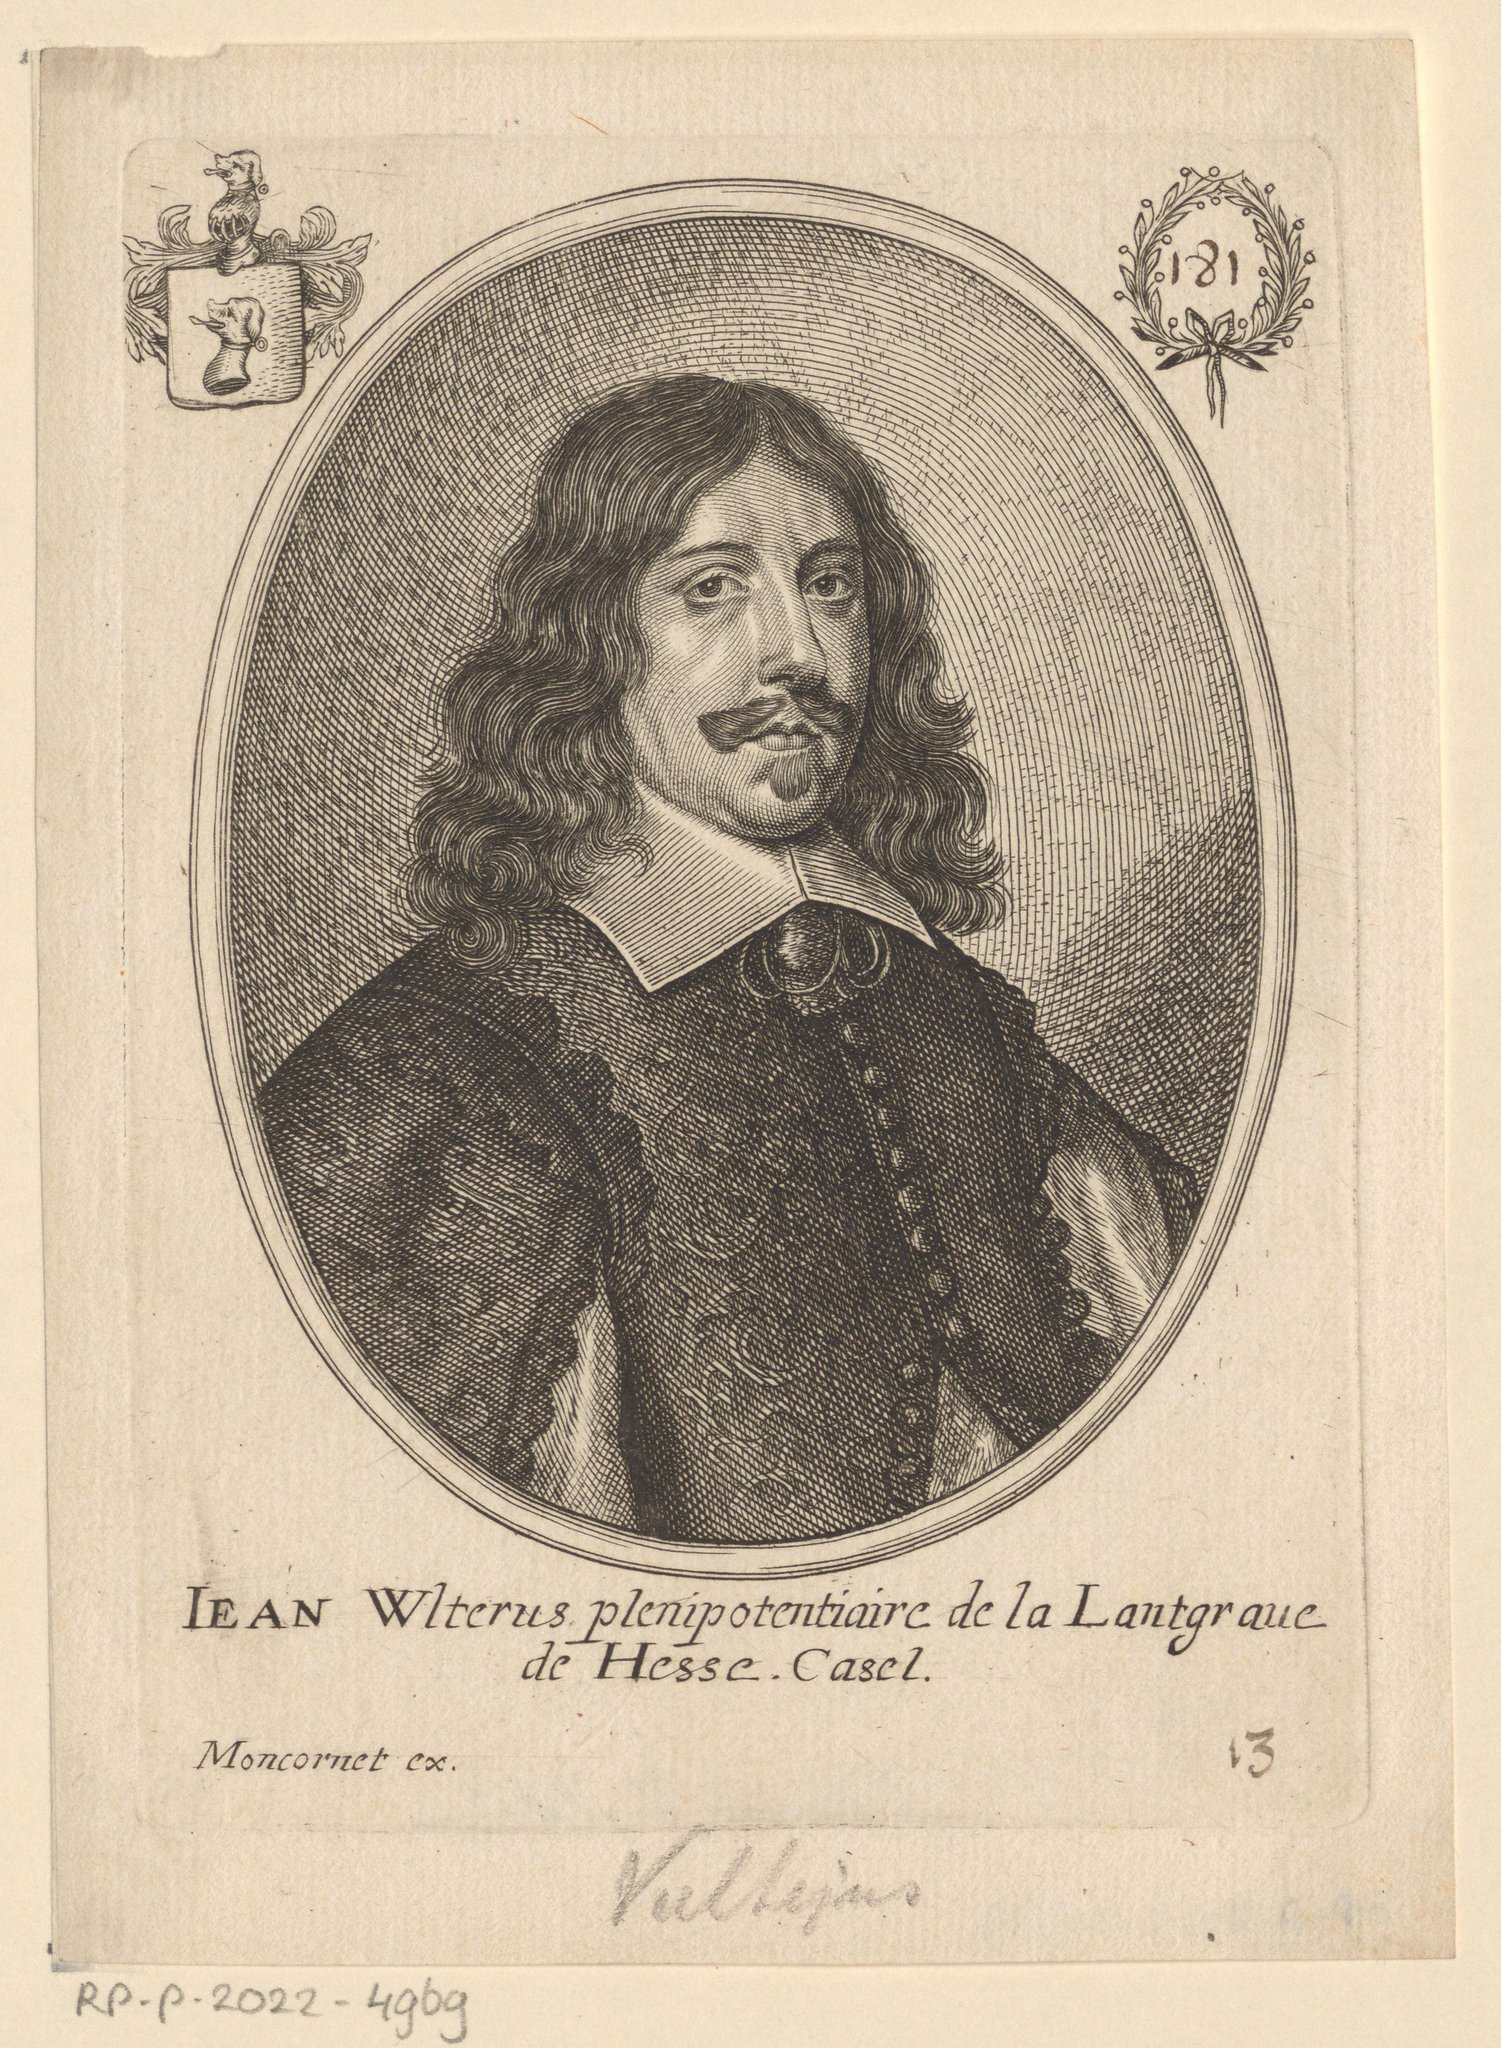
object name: print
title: Portret van Johann Vultejus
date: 1641-1668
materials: paper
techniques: engraving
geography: france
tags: official; civil servant; functionary (in general), historical persons, armorial bearing, heraldry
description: Rechtsonder handgeschreven genummerd: 13. Rechtsboven handgeschreven genummerd: 181.